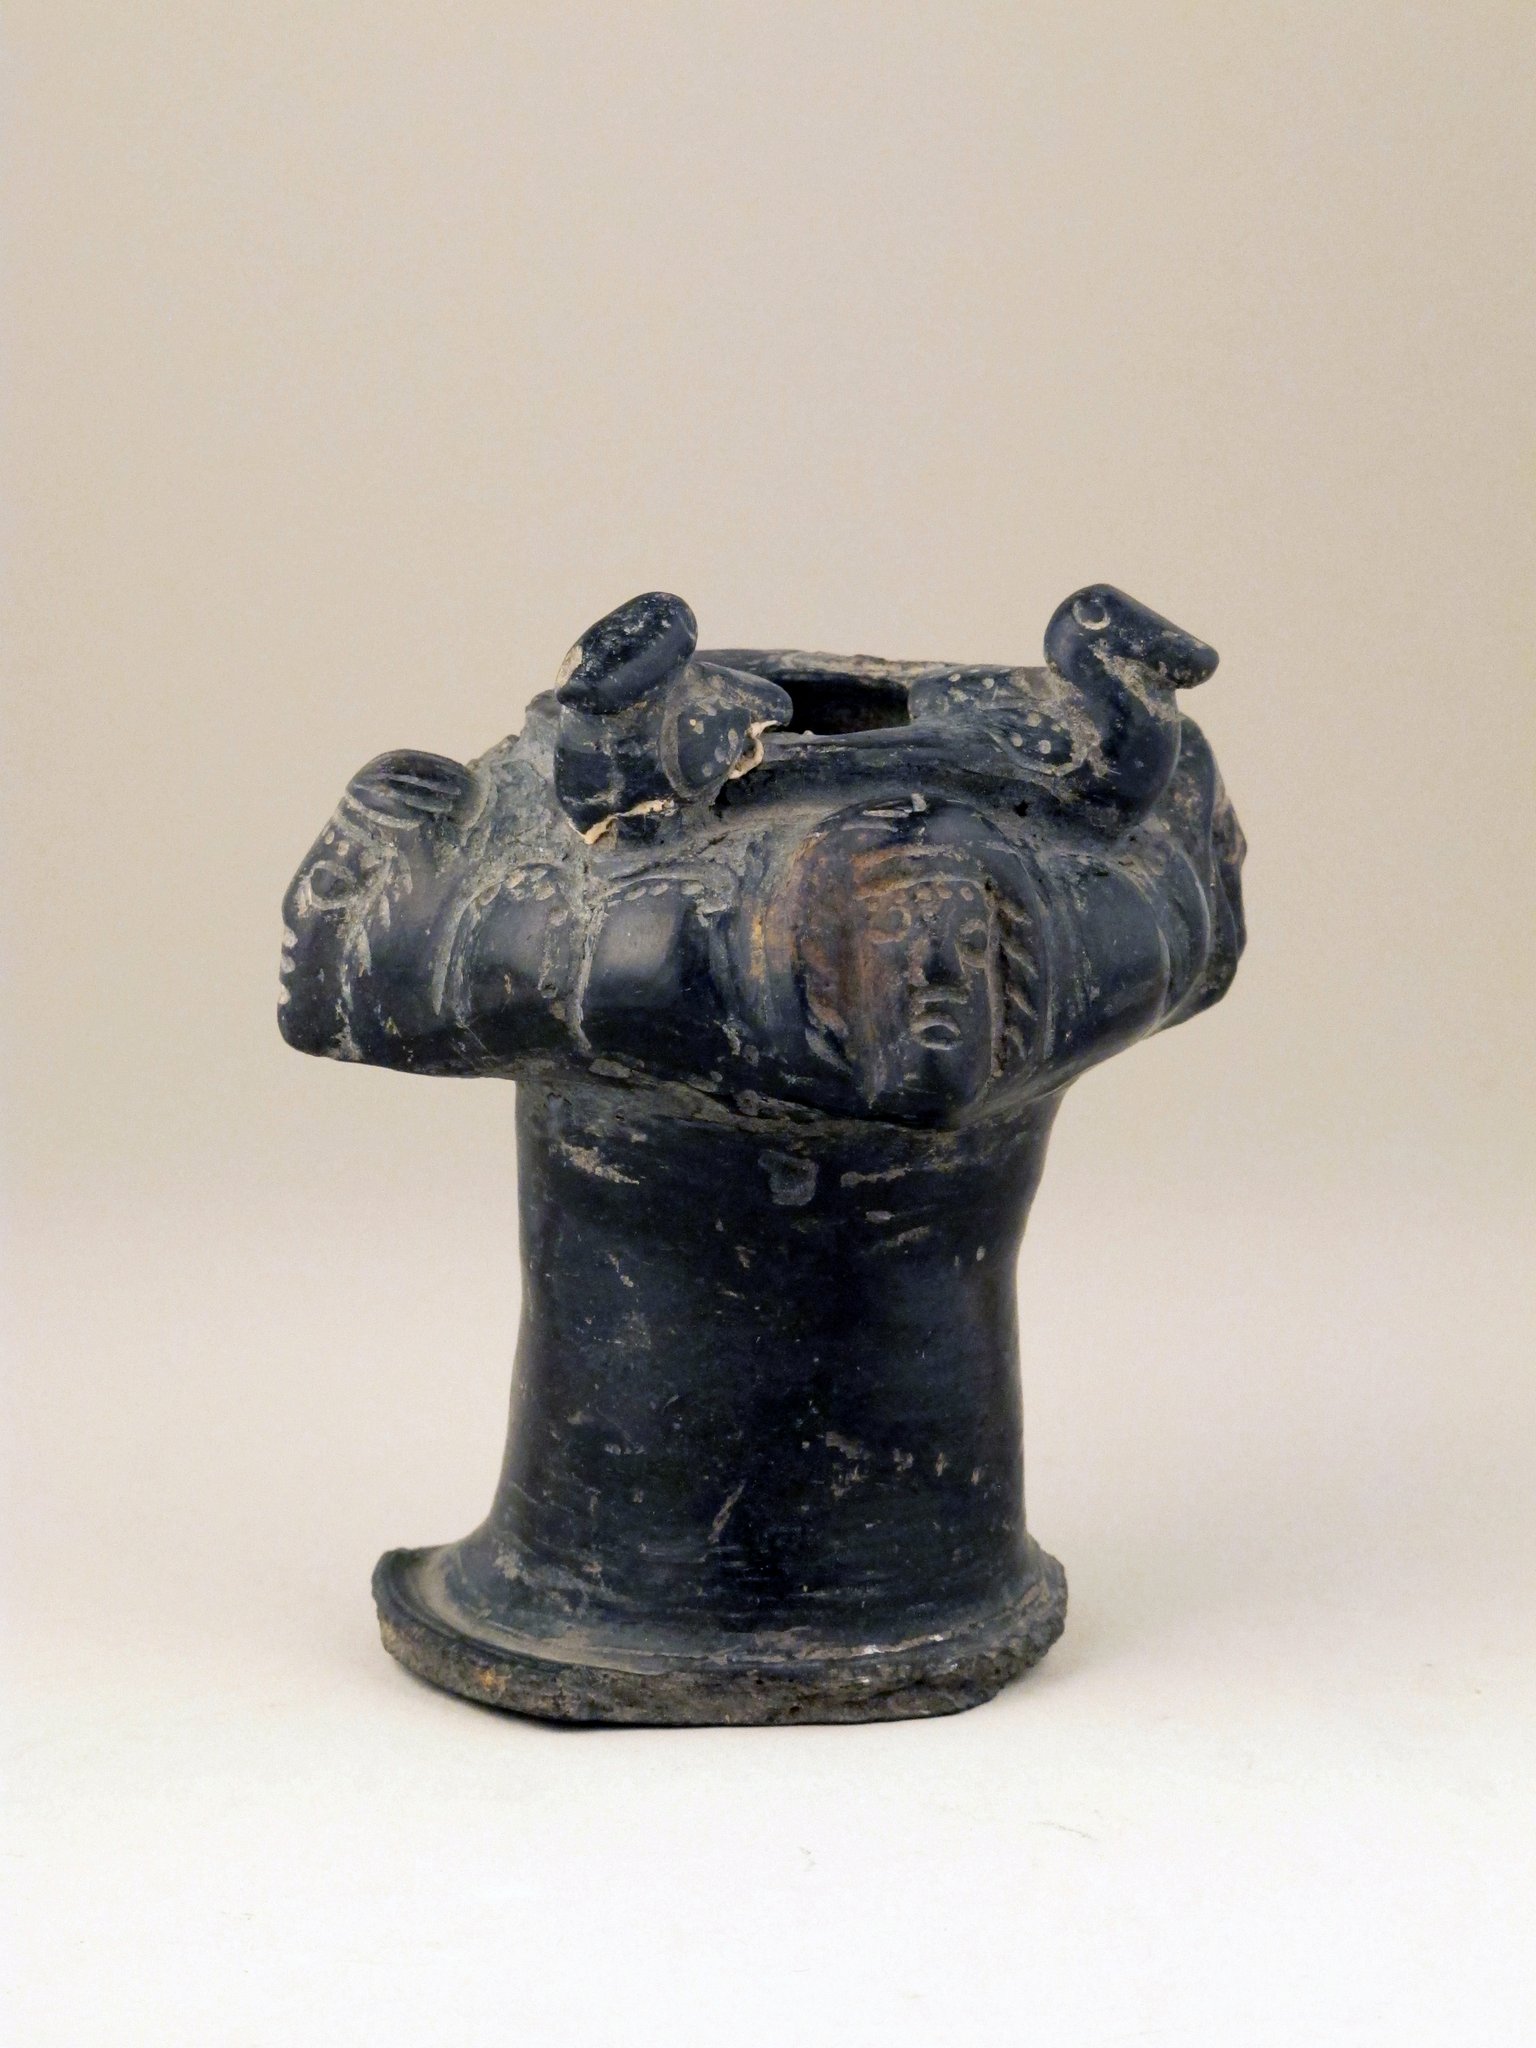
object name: vase fragment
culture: etruscan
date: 575-550 BCE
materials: terracotta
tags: birds,heads